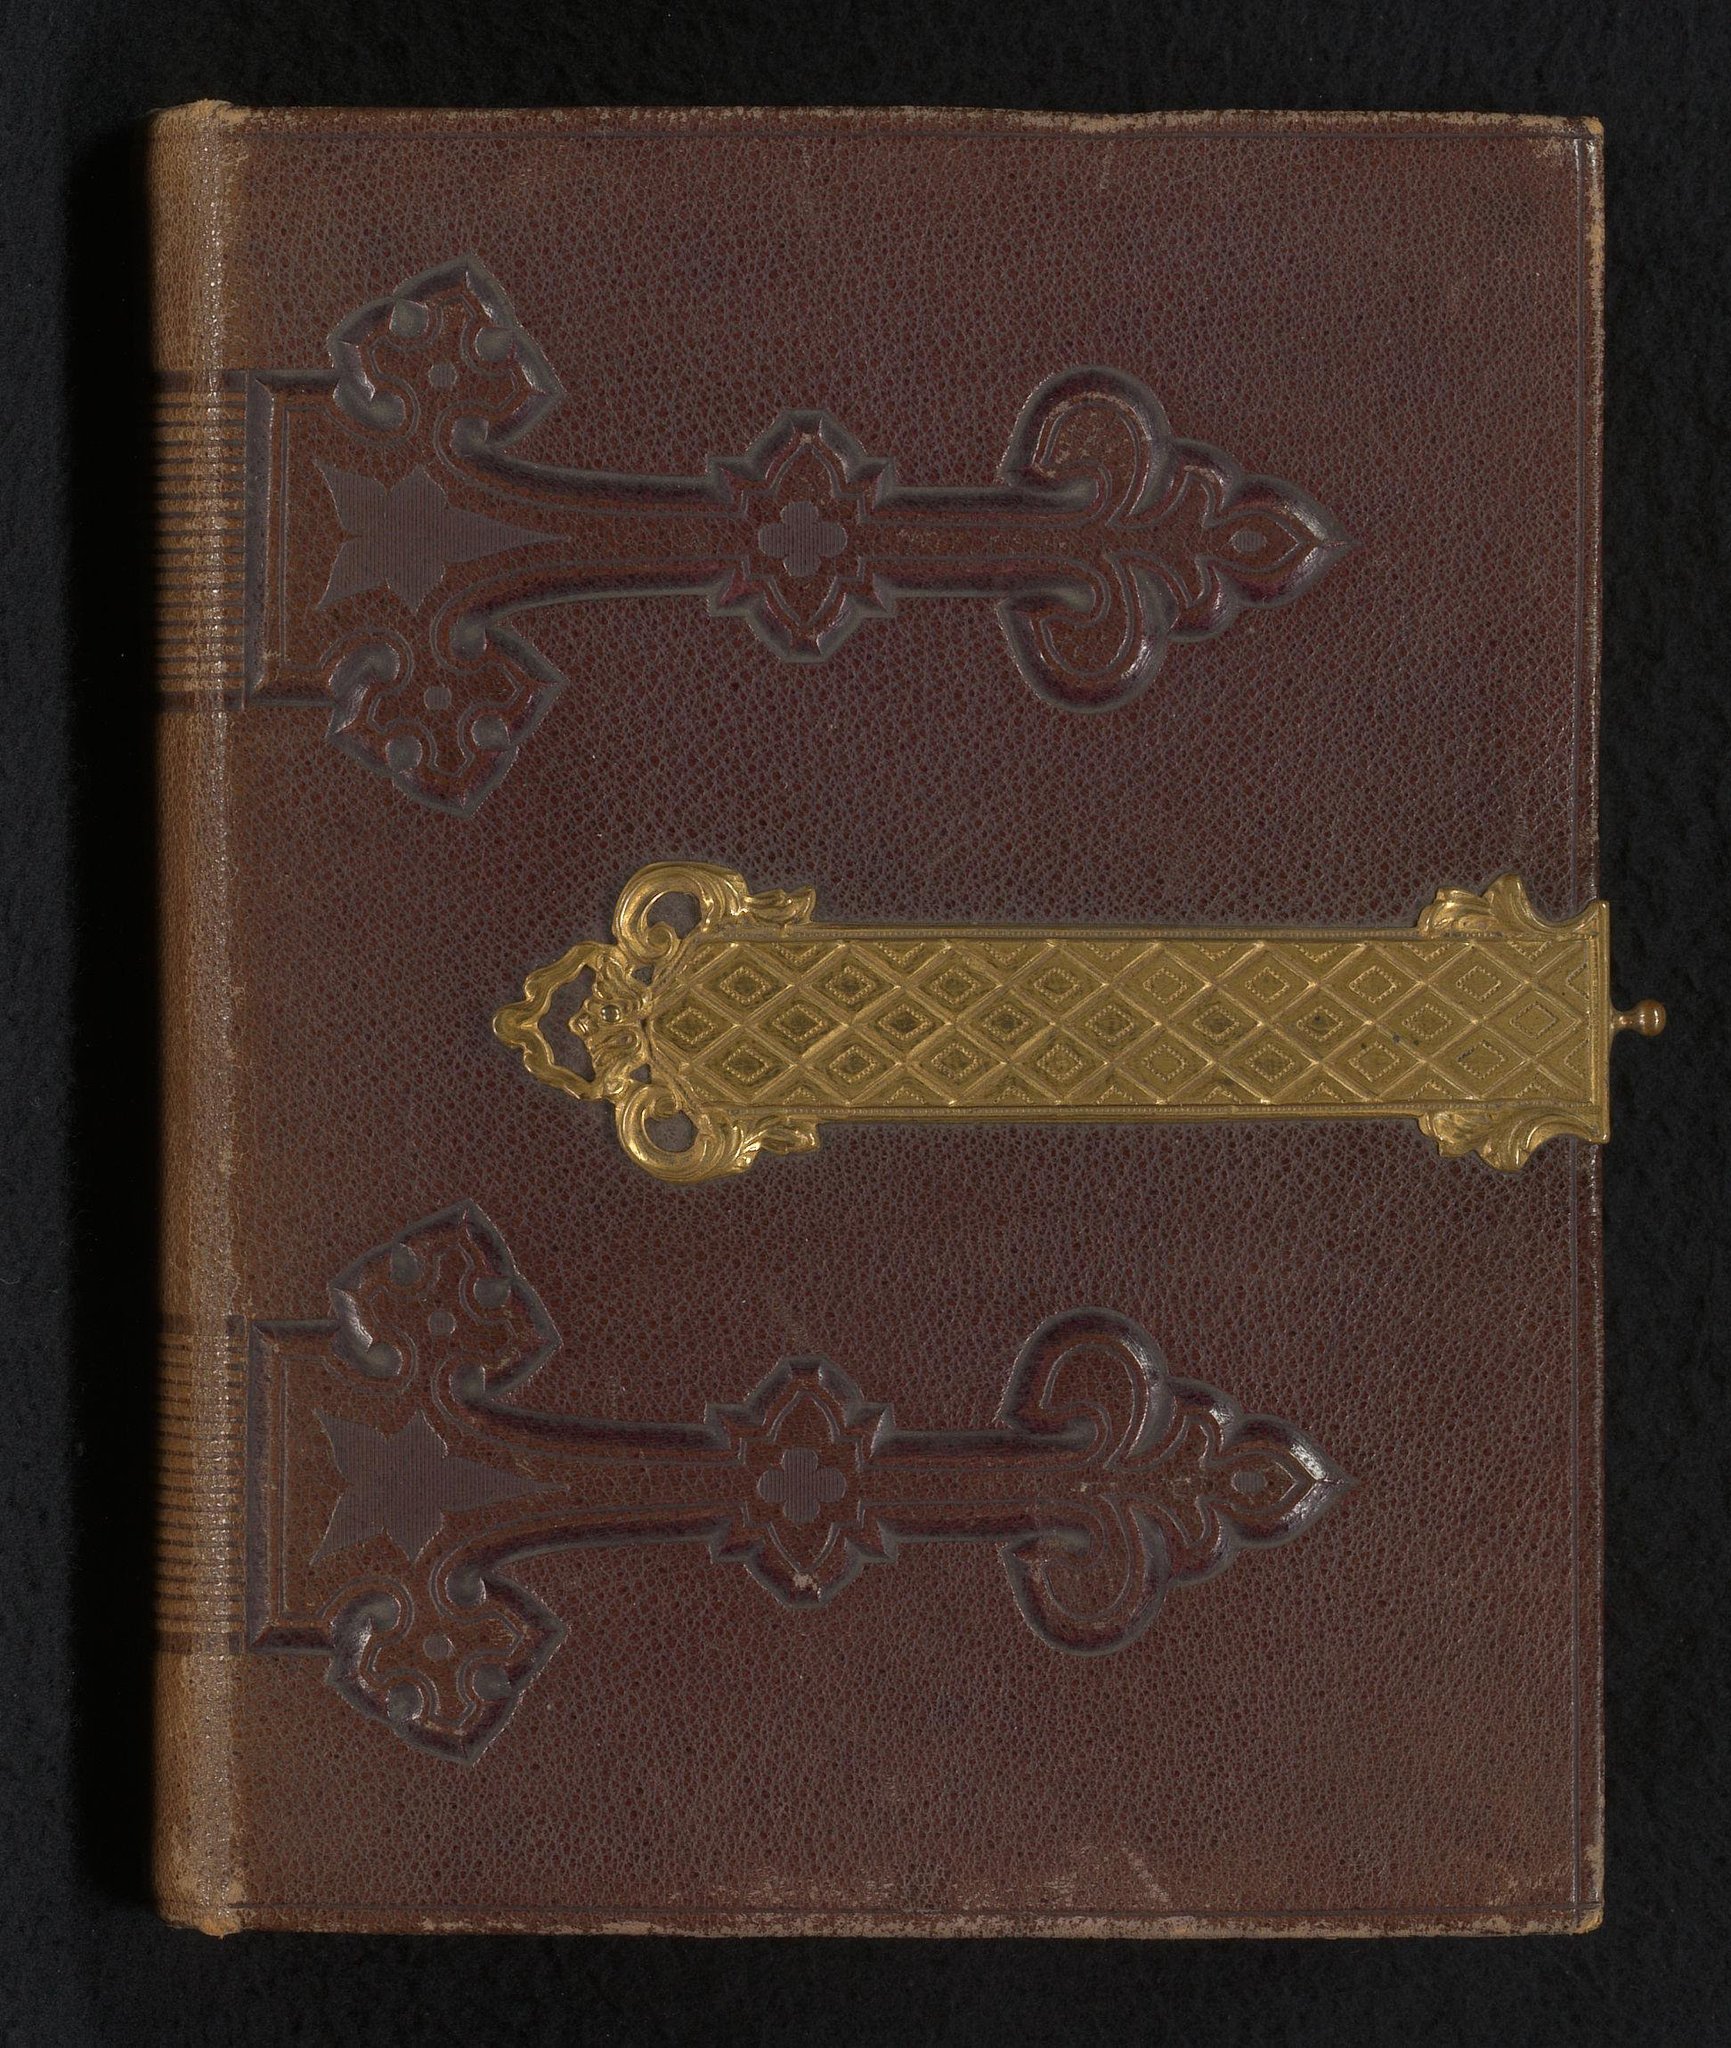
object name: photograph album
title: Carte-de-visite-album van de familie Boelen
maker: Anonymous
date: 1860-1880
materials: brass, cardboard, leather, paper, textile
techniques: albumen print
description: Insteekalbum met 34 cartes-de-visite, en 1 bijgesneden kabinetfoto, met portretten van leden van de familie Boelen.